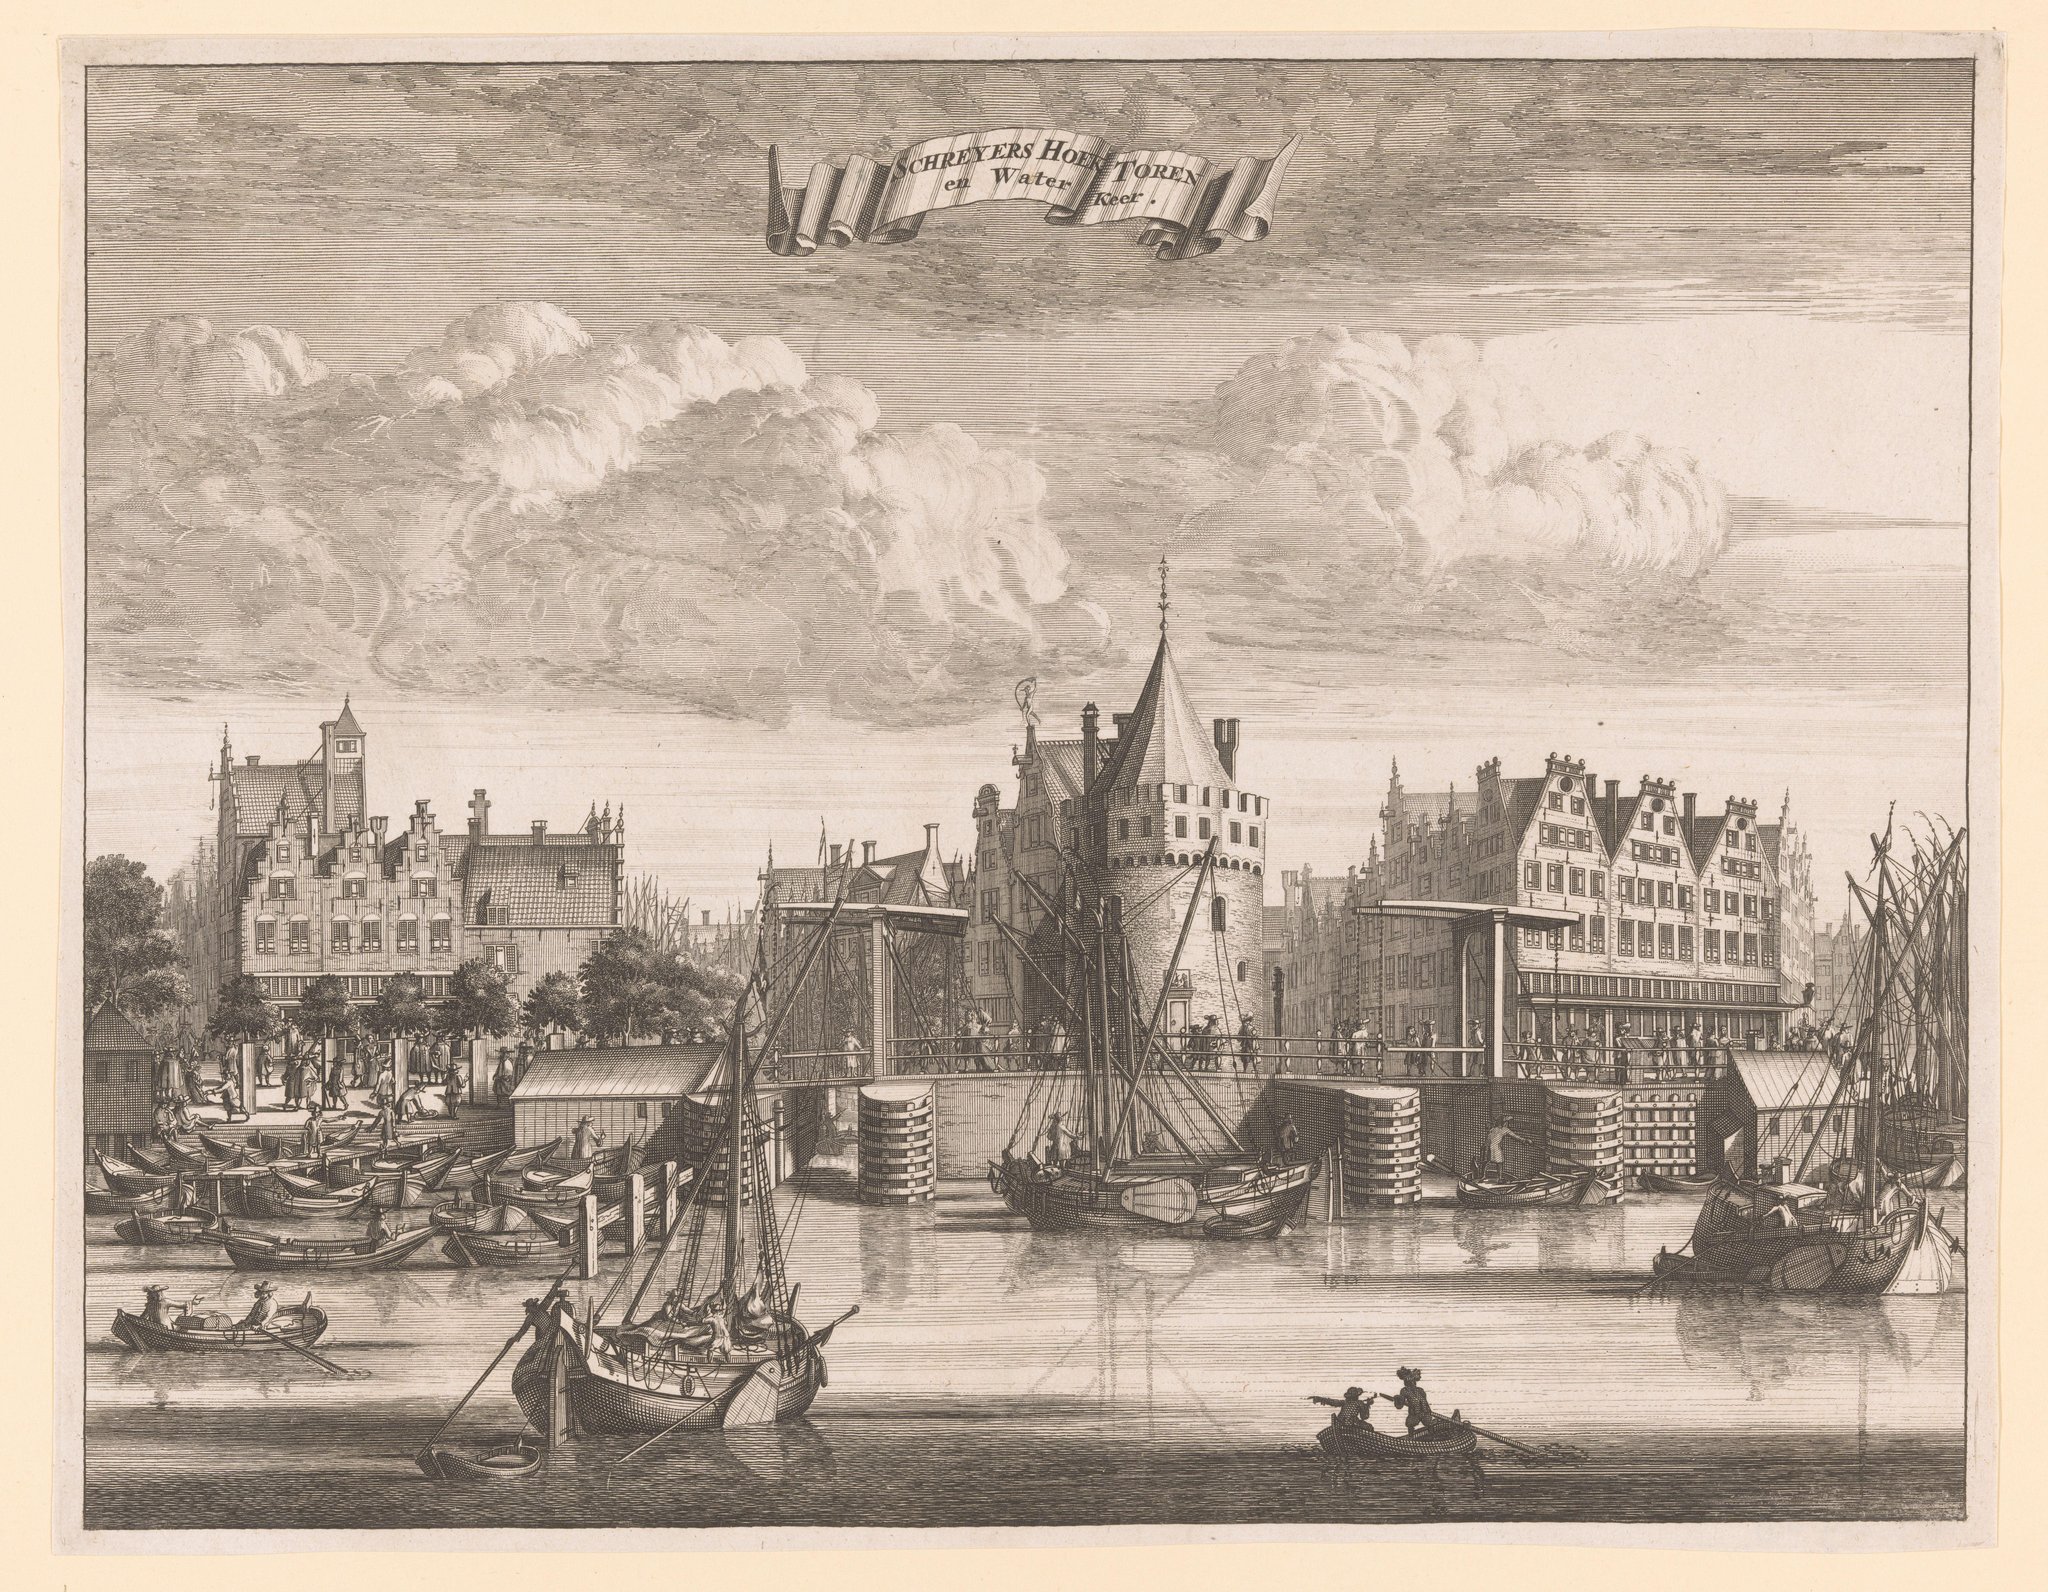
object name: print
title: Schreyers Hoek Toren en Water Keer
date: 1693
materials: paper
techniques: engraving, etching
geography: amsterdam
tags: urban housing, sailing-ship, sailing-boat, towers ~ fortified city, rowing-boat, canoe, etc., bridge in city across river, canal, etc.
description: Prent uit: Commelin, Caspar. Beschryvinge van Amsterdam (...). 2 dln. Amsterdam: Abraham Wolfgang et al., 1693, dl. 2, p. 704-705. En in latere edities van dit werk (Amsterdam: Weduwe Aart Dircksz. Oossaan, 1694 en Amsterdam: Andries van Damme et al., 1726).